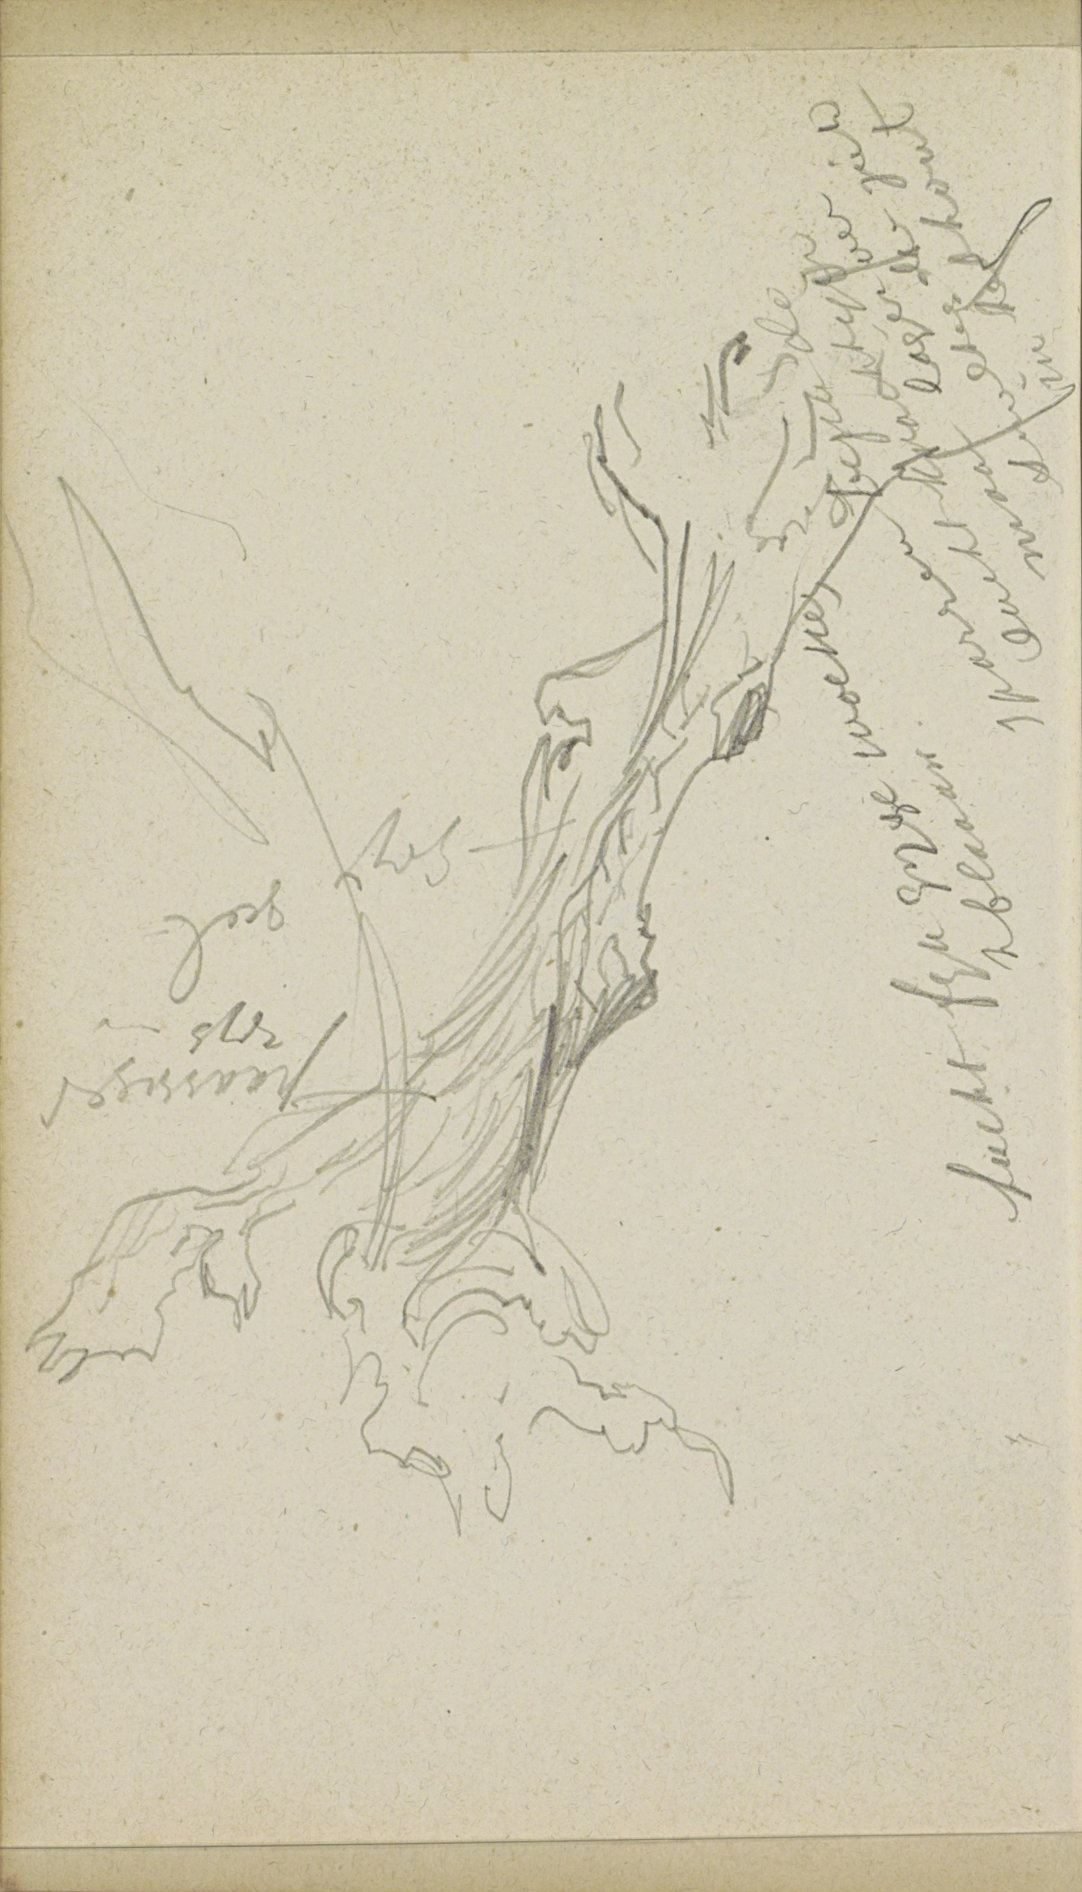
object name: sketchbook leaf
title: Boomstam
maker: johannes tavenraat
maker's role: draughtsman, painter, print maker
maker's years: 1809-1881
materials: paper, pencil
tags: trees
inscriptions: kleurnotitie, handgeschreven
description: Blad 37 verso uit een schetsboek met 88 bladen.